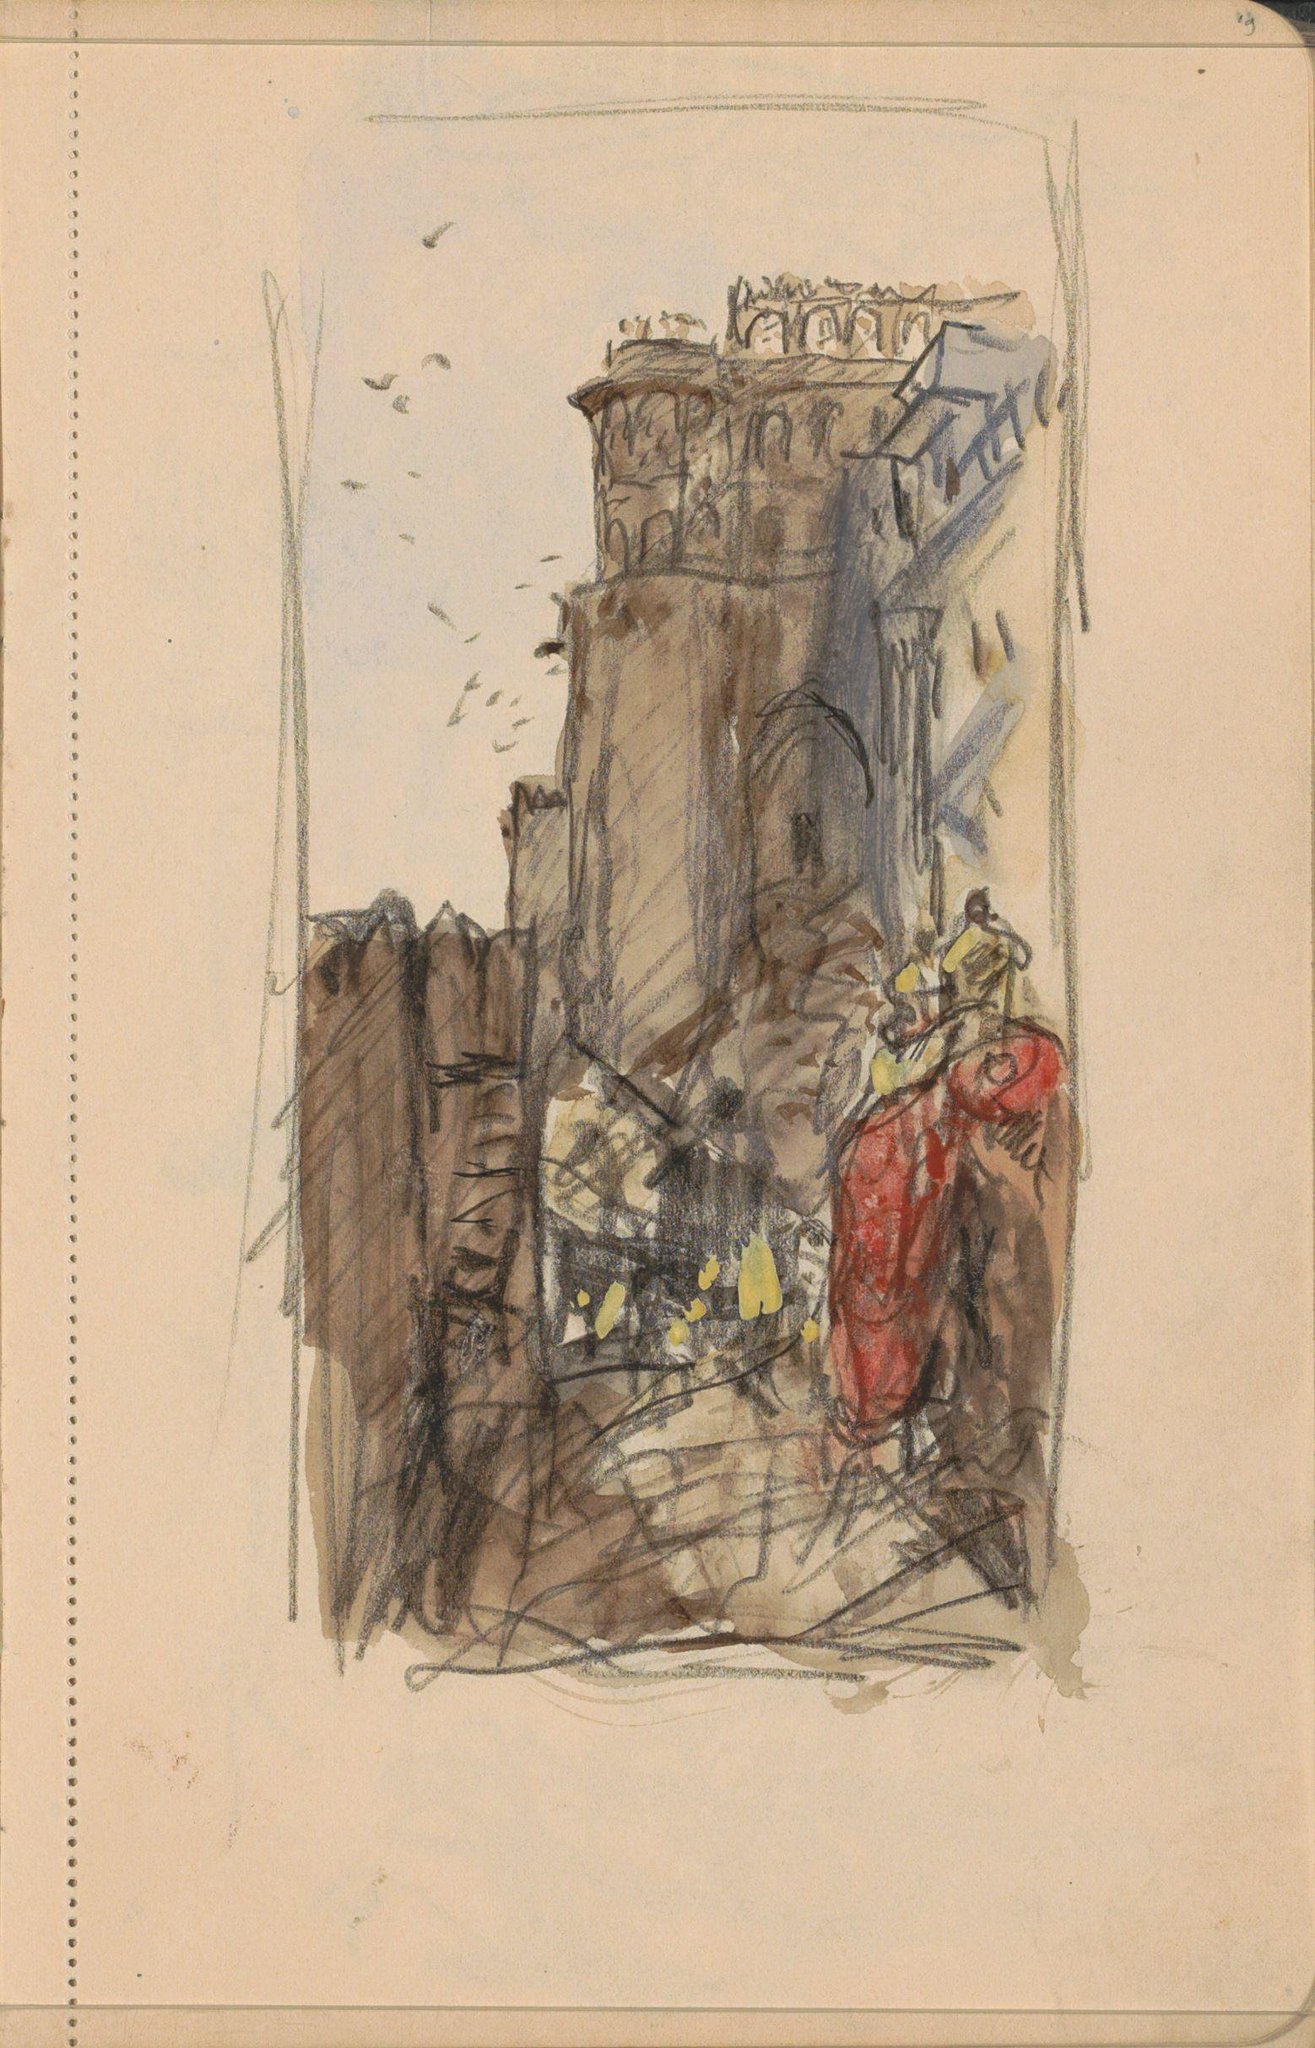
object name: sketchbook leaf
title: Straat met figuren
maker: marius bauer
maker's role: draughtsman, print maker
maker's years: 1867-1932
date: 1924-1925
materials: paper, pencil, watercolor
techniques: brush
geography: india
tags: street (+ city(-scape) with figures, staffage)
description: Pagina 19 uit een schetsboek met 87 bladen.